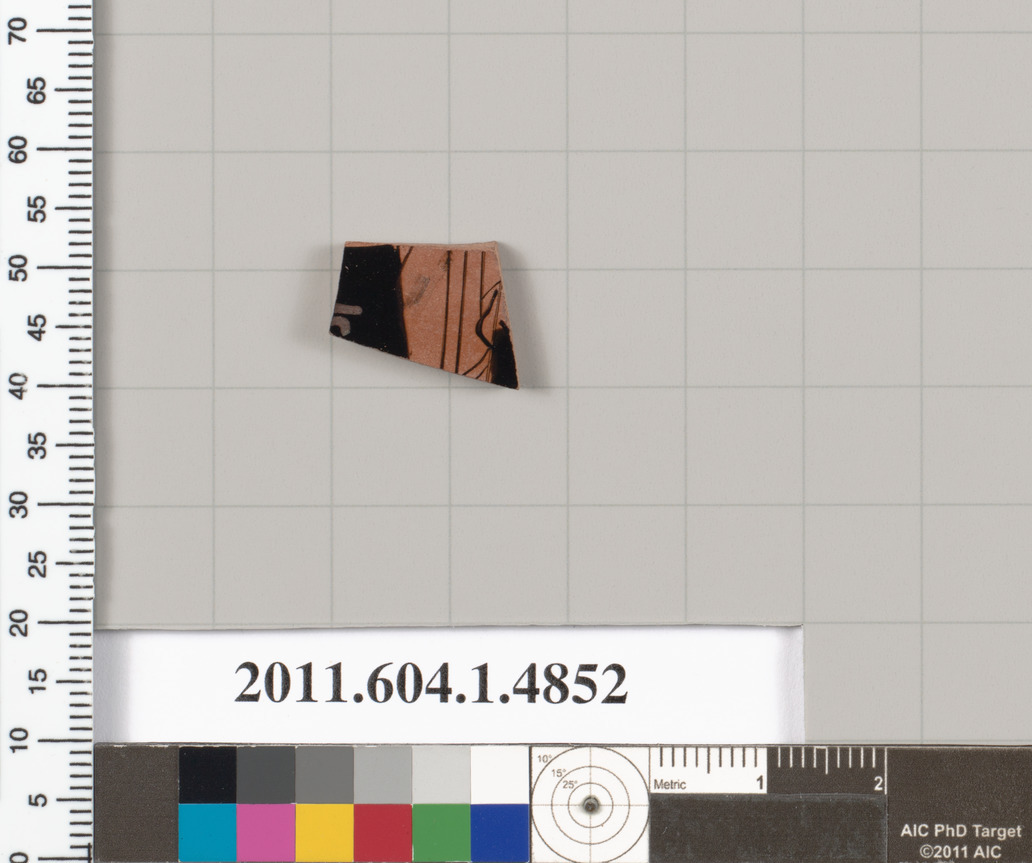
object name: kylix fragment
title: Terracotta fragment of a kylix (drinking cup)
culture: greek, attic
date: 520-490 BCE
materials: terracotta